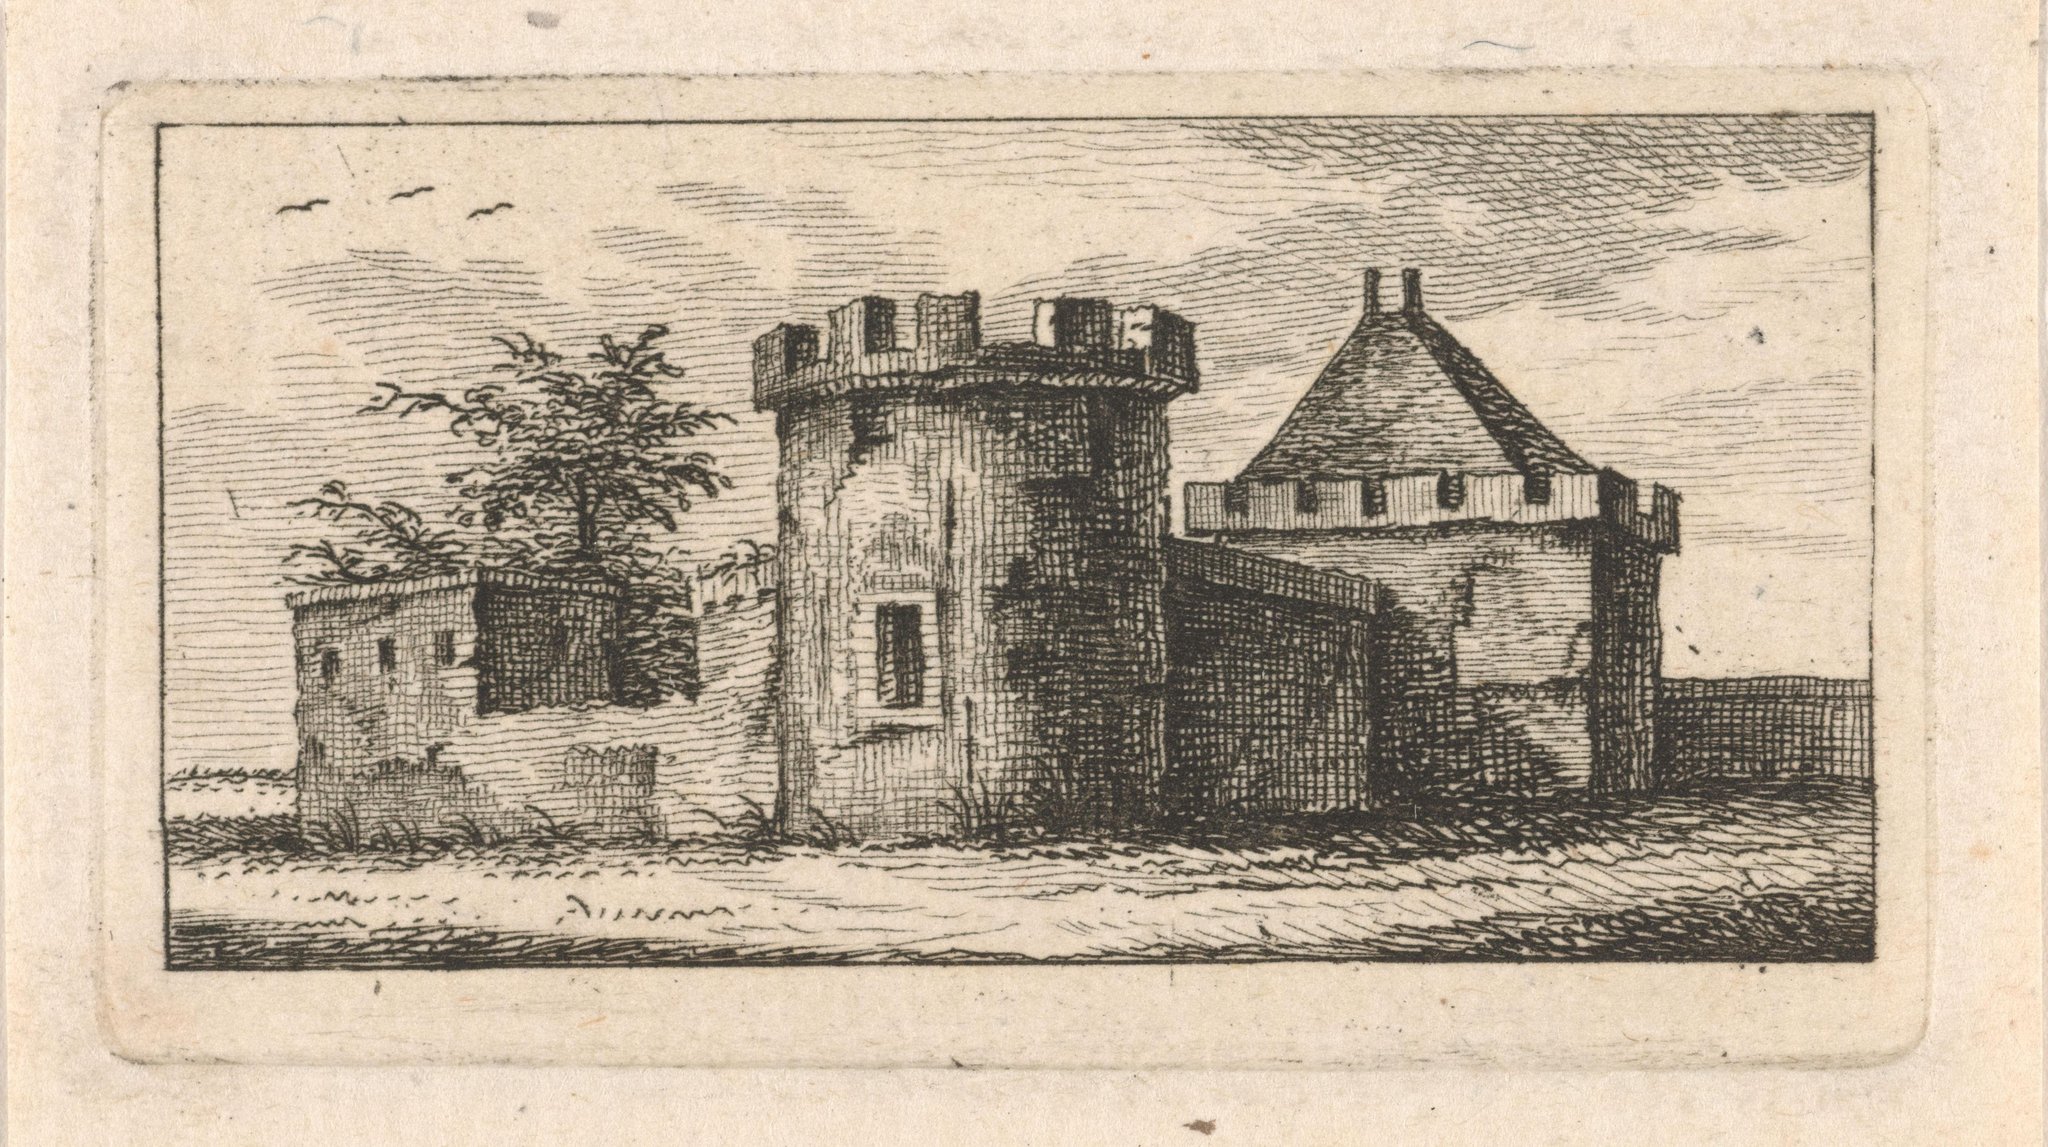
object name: print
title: Landschap met een fort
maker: caspar jacobsz. philips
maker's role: draughtsman, print maker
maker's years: 1732-1789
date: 1766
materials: paper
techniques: etching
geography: amsterdam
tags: fortress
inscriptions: collector's mark: Lugt 240